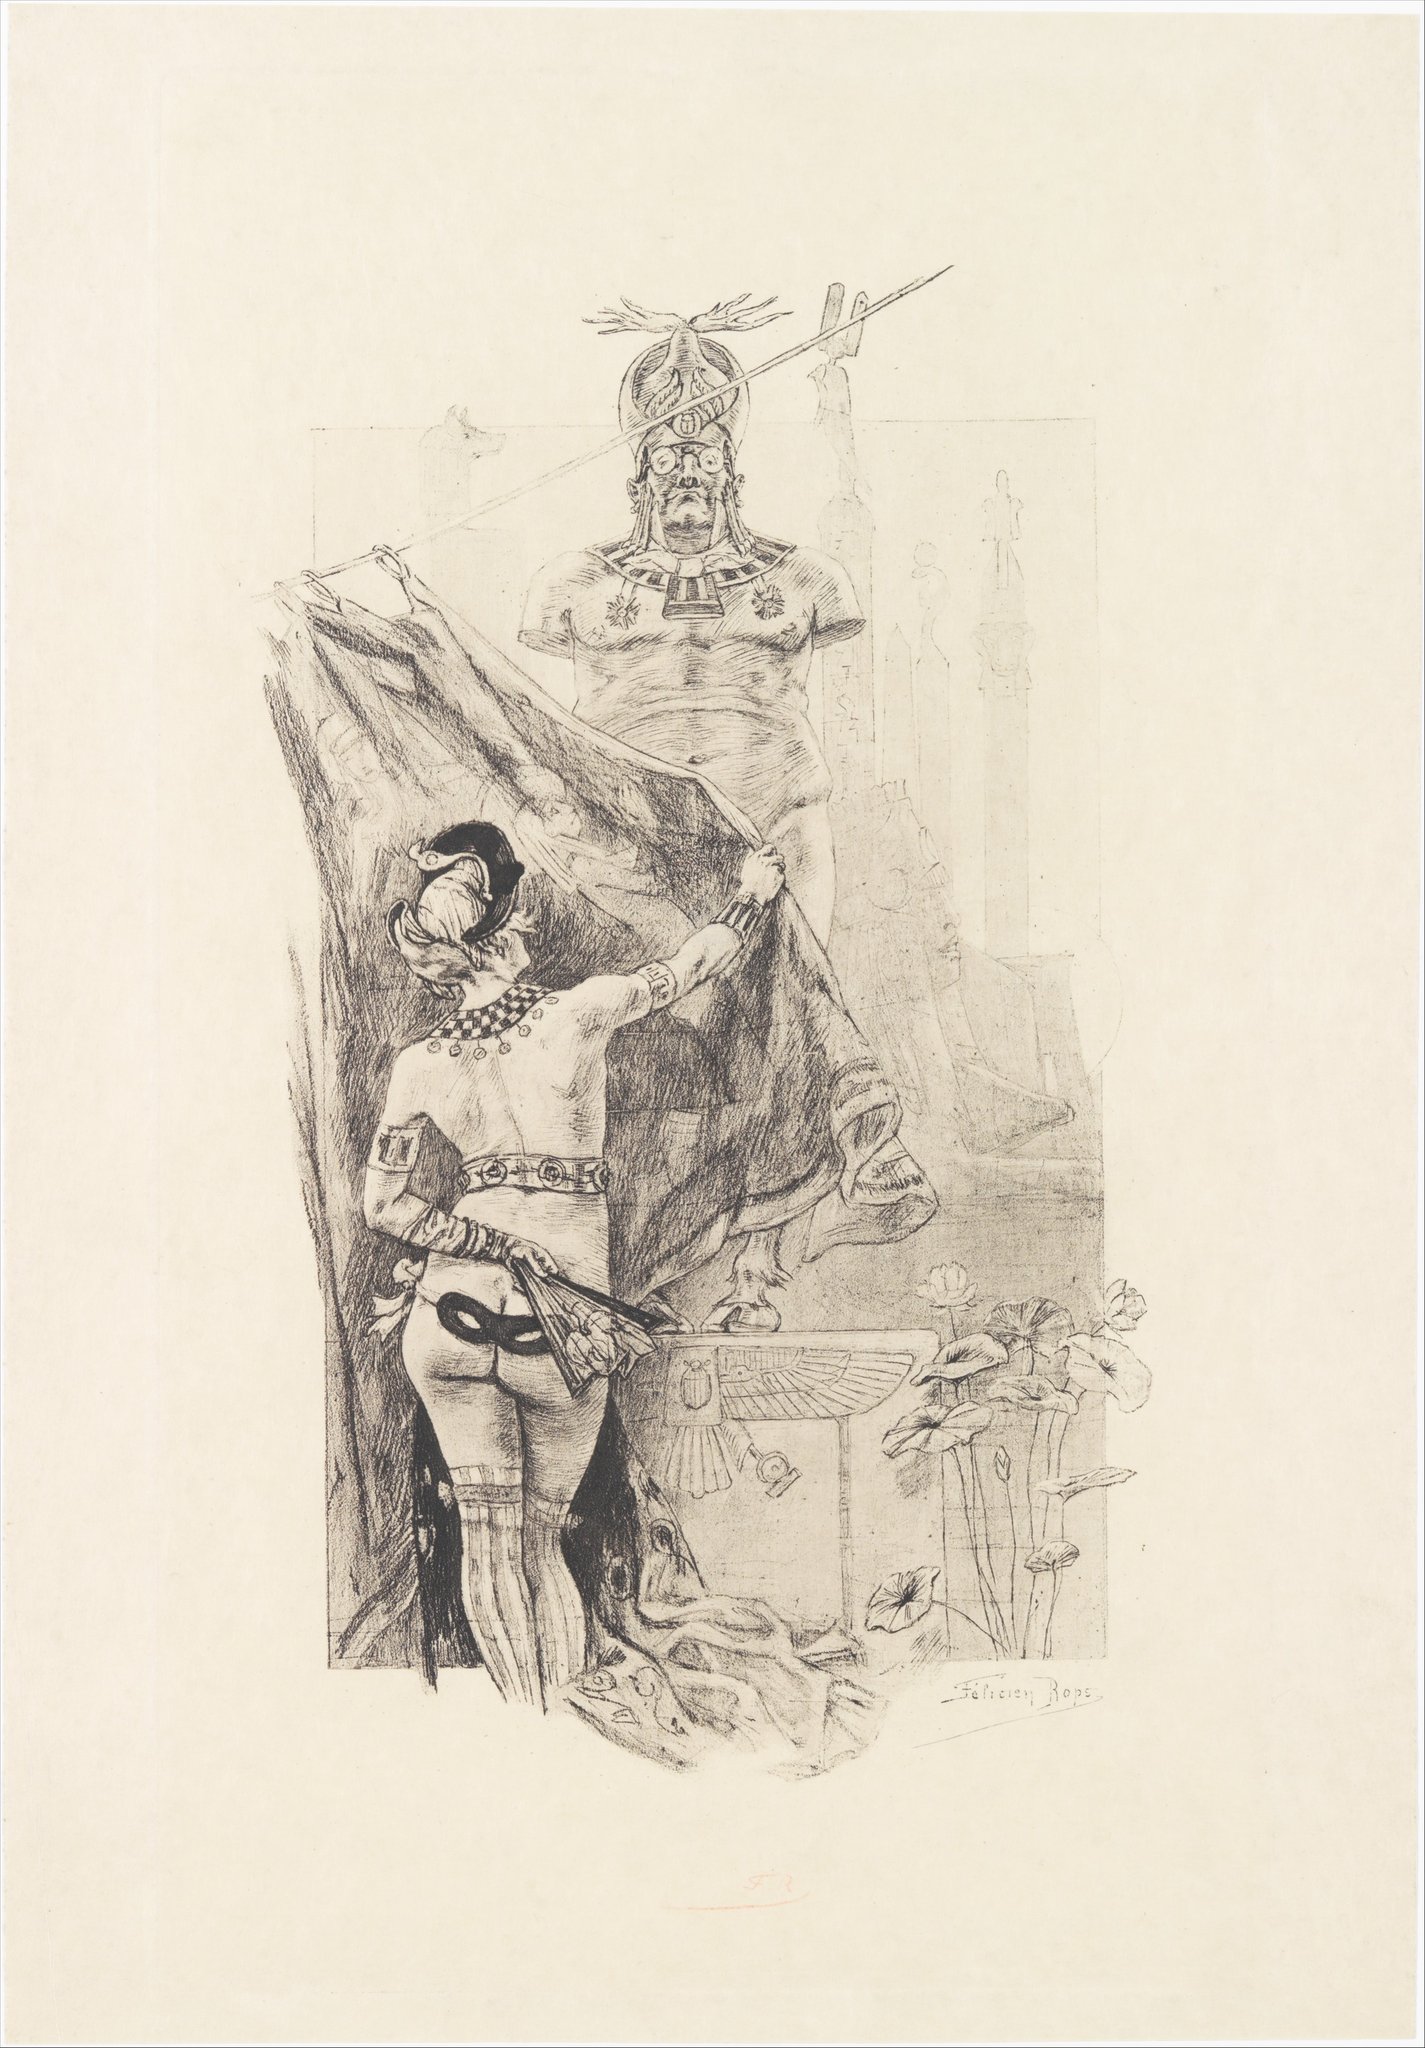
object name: print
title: Sodom's Modesty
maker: félicien rops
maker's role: artist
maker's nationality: belgian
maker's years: 1833-1898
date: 1888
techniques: etching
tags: sculpture,women